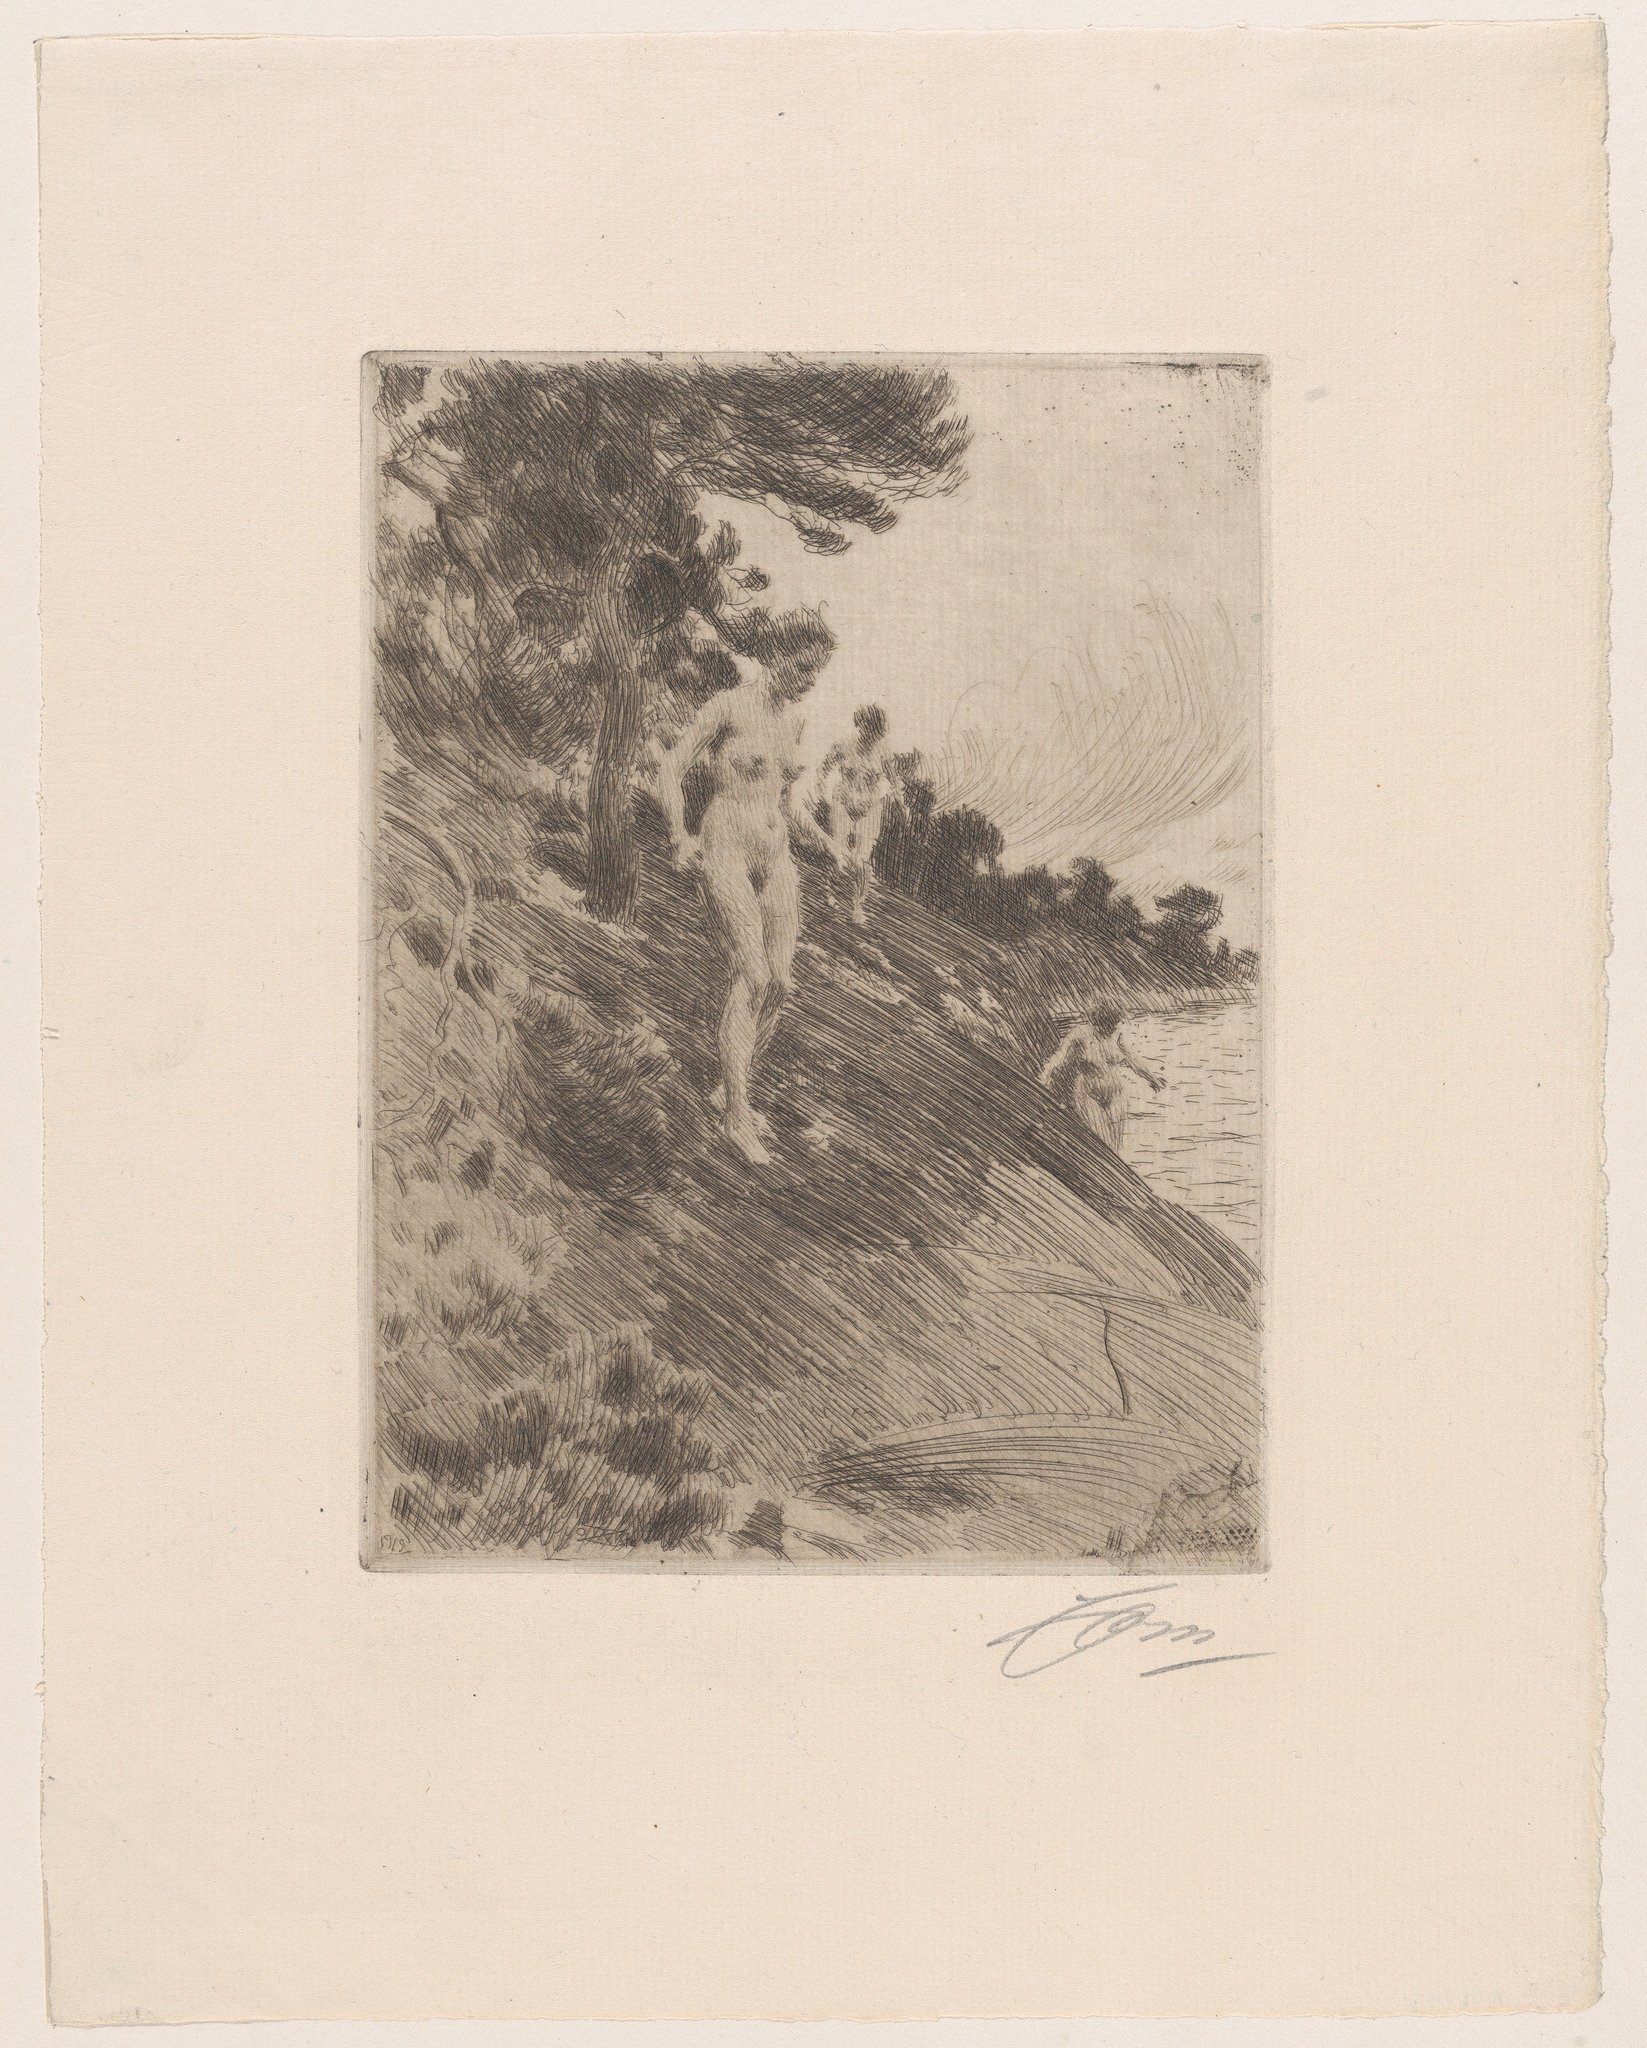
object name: print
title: Frightened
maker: anders zorn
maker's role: artist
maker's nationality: swedish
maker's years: 1860-1920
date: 1912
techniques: etching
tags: female nudes